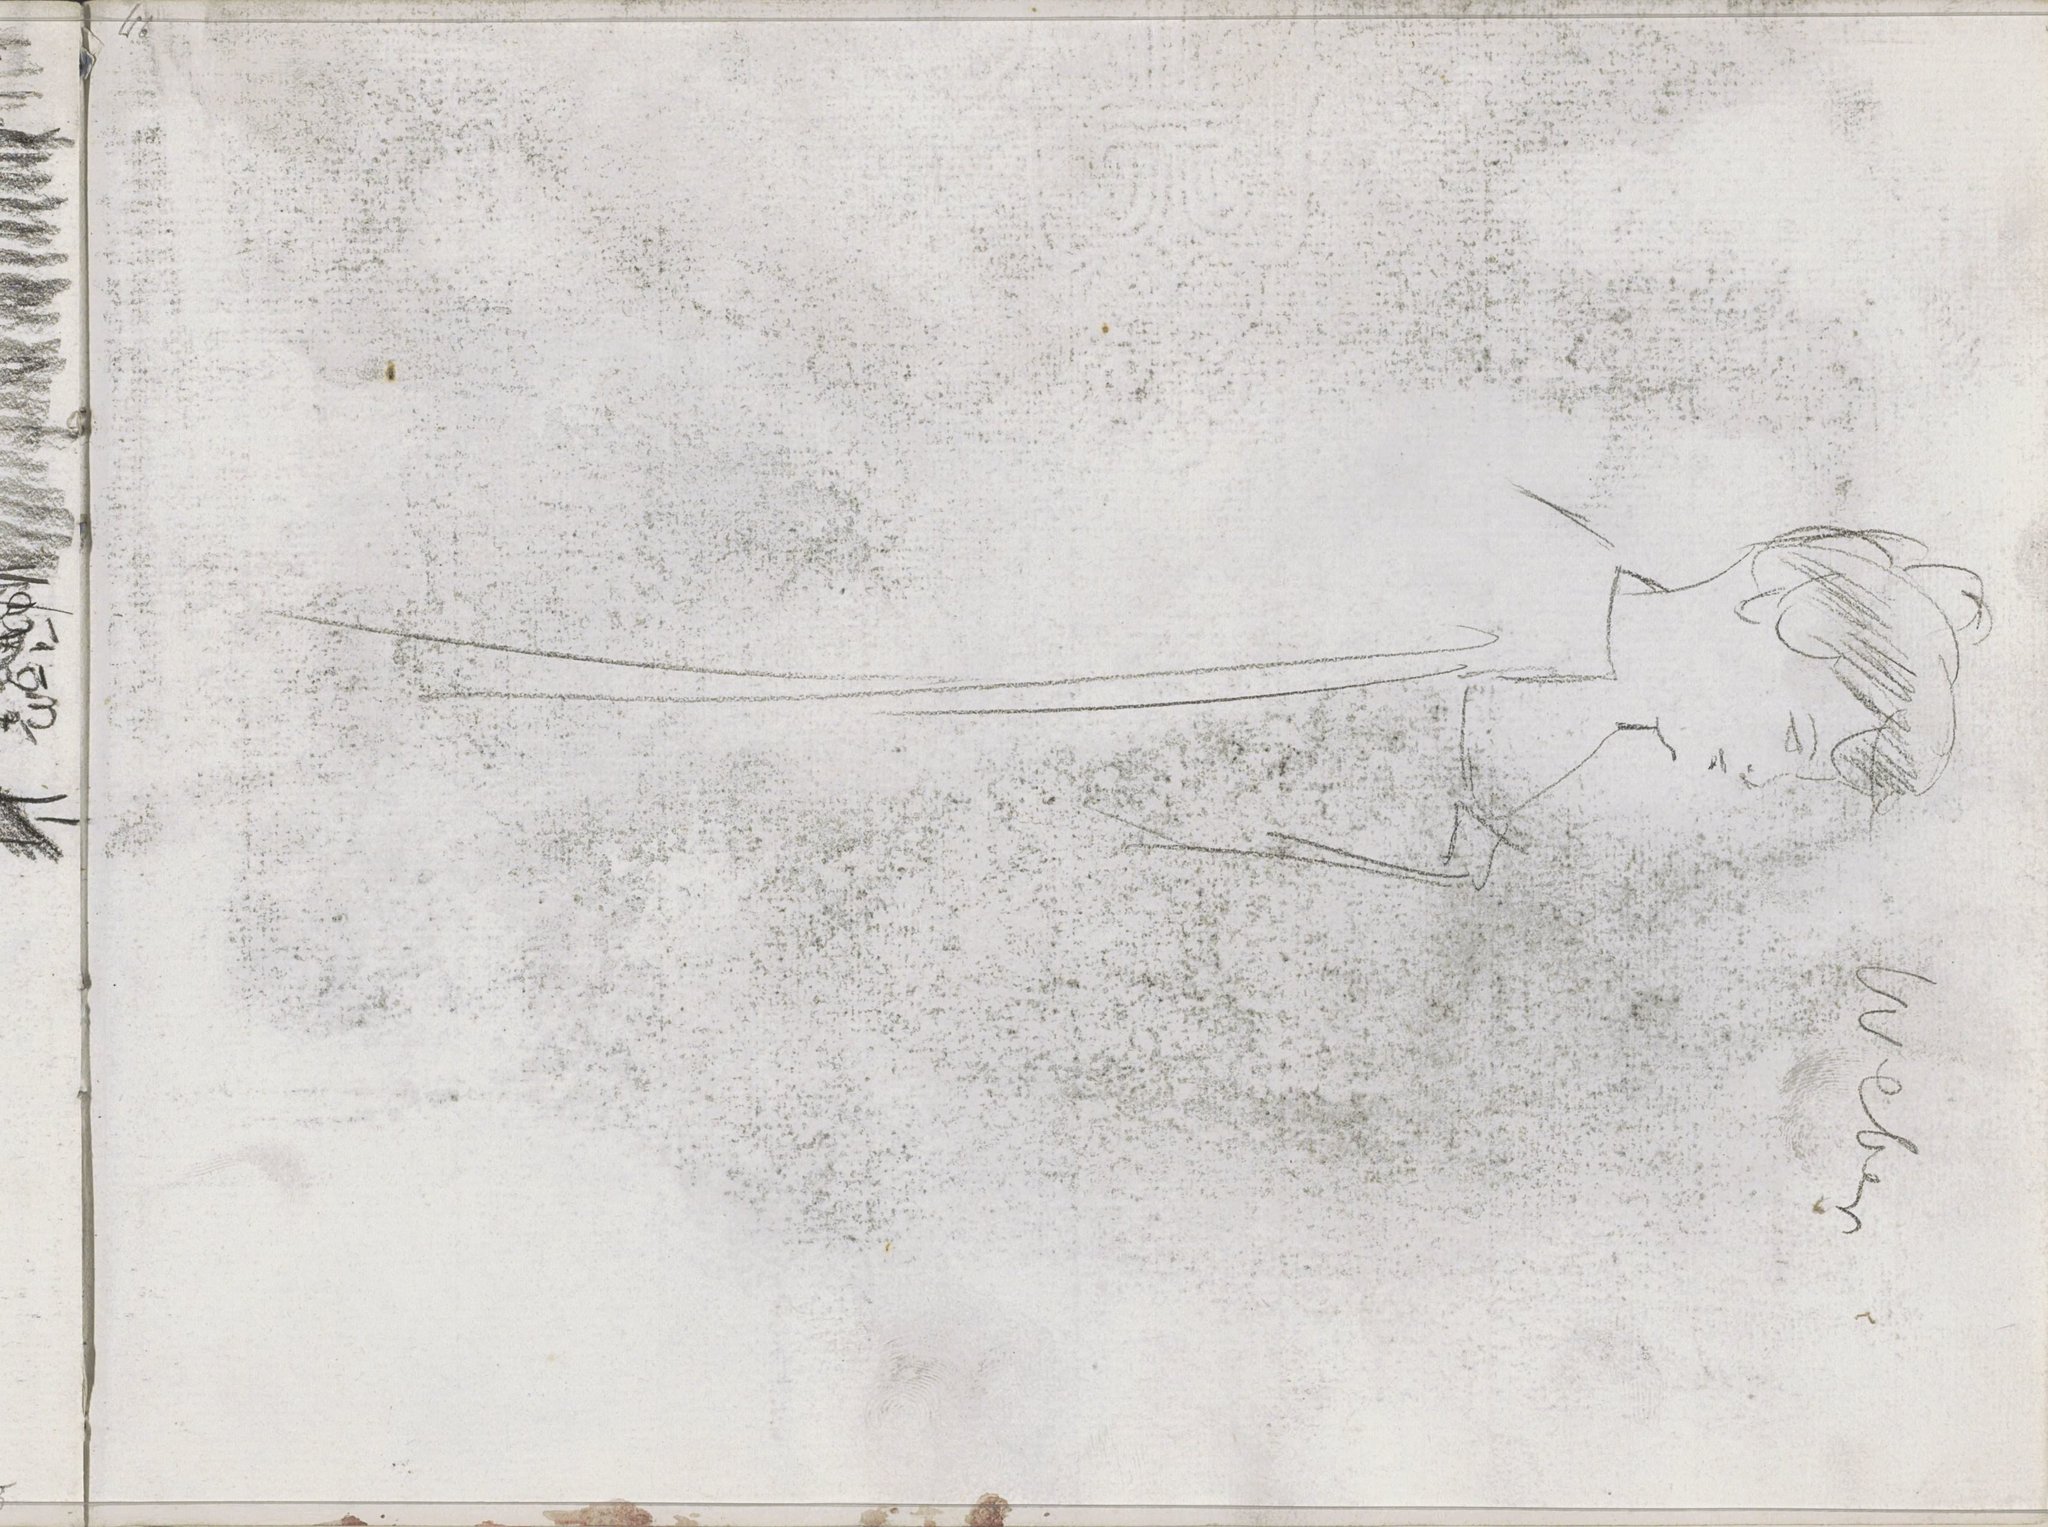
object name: sketchbook leaf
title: Staande vrouw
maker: isaac israels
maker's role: draughtsman, painter, print maker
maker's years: 1865-1934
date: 1875-1934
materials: chalk, paper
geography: the hague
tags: adult woman (+ standing)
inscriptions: annotation: ‘Weber’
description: Mogelijk mevrouw Weber. Blad 5 recto uit schetsboek XXII met 30 bladen.